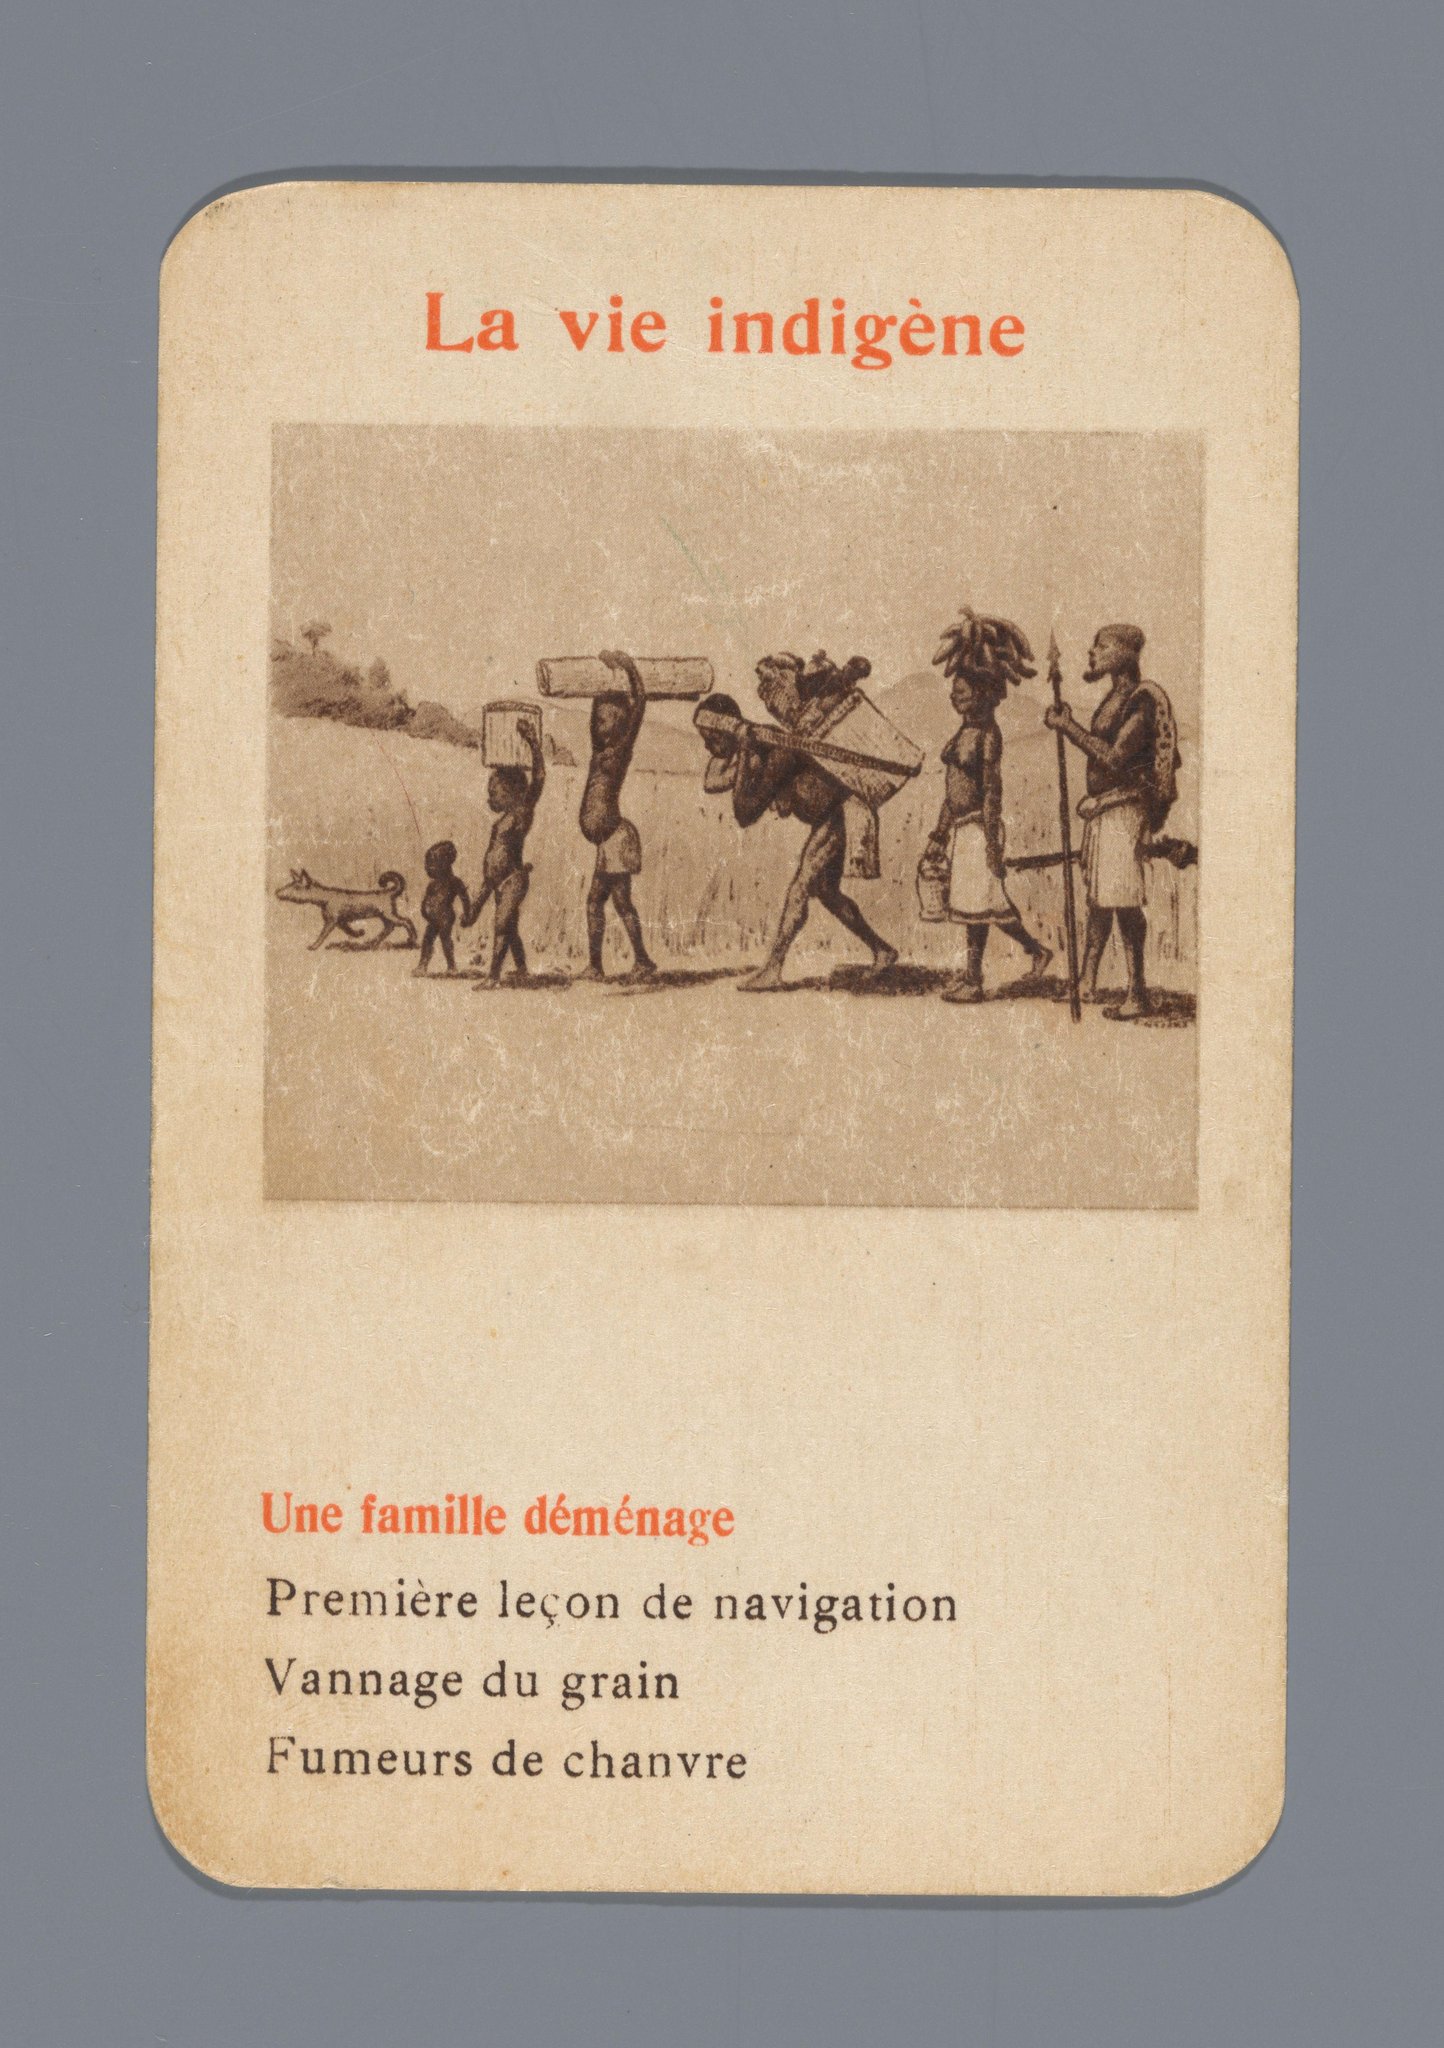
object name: reproduction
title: La vie indigène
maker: Anonymous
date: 1900-1920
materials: cardboard, paper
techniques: rotogravure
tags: moving (house), card games